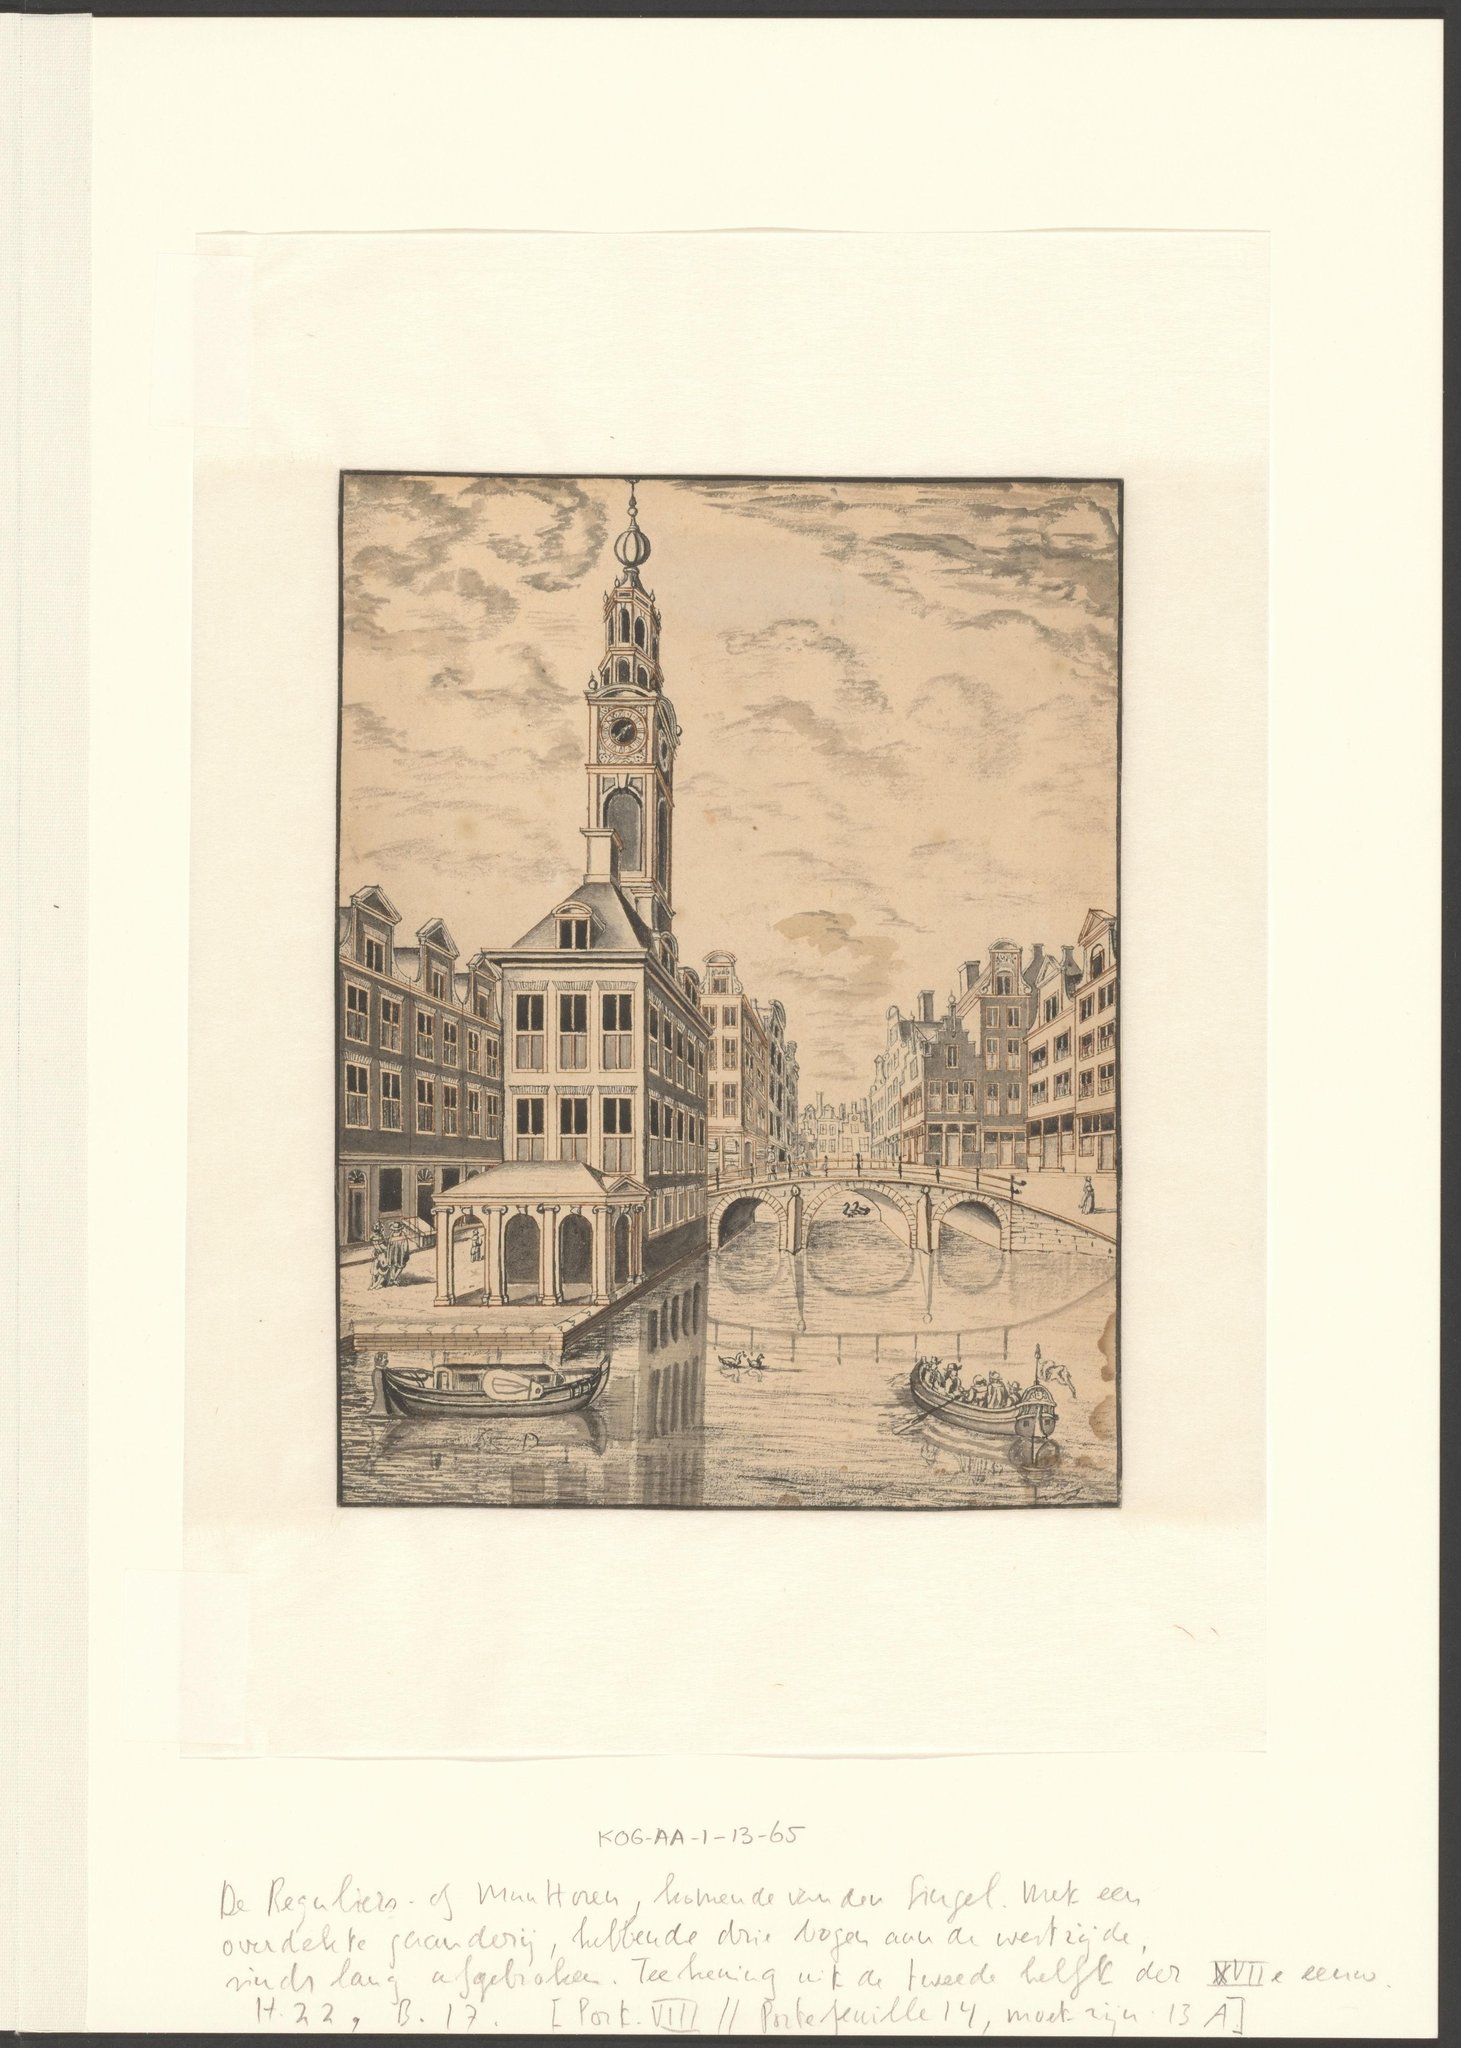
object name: drawing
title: Gezicht op de Munttoren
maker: Anonymous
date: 1650-1750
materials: chalk, ink, paper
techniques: brush, pen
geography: amsterdam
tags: tower, clock tower ~ monumental adornment, city-view in general; 'veduta', canal, bridge in city across river, canal, etc.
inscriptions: inscription: ‘No 7 / De Reguliers Toren te Amsterdam’, inscription: ‘13-65BIS’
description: Onderwerpsrubriek binnen de Atlas Amsterdam: Oude Schans, Schoutensteeg, Singel (Korte), Singel.